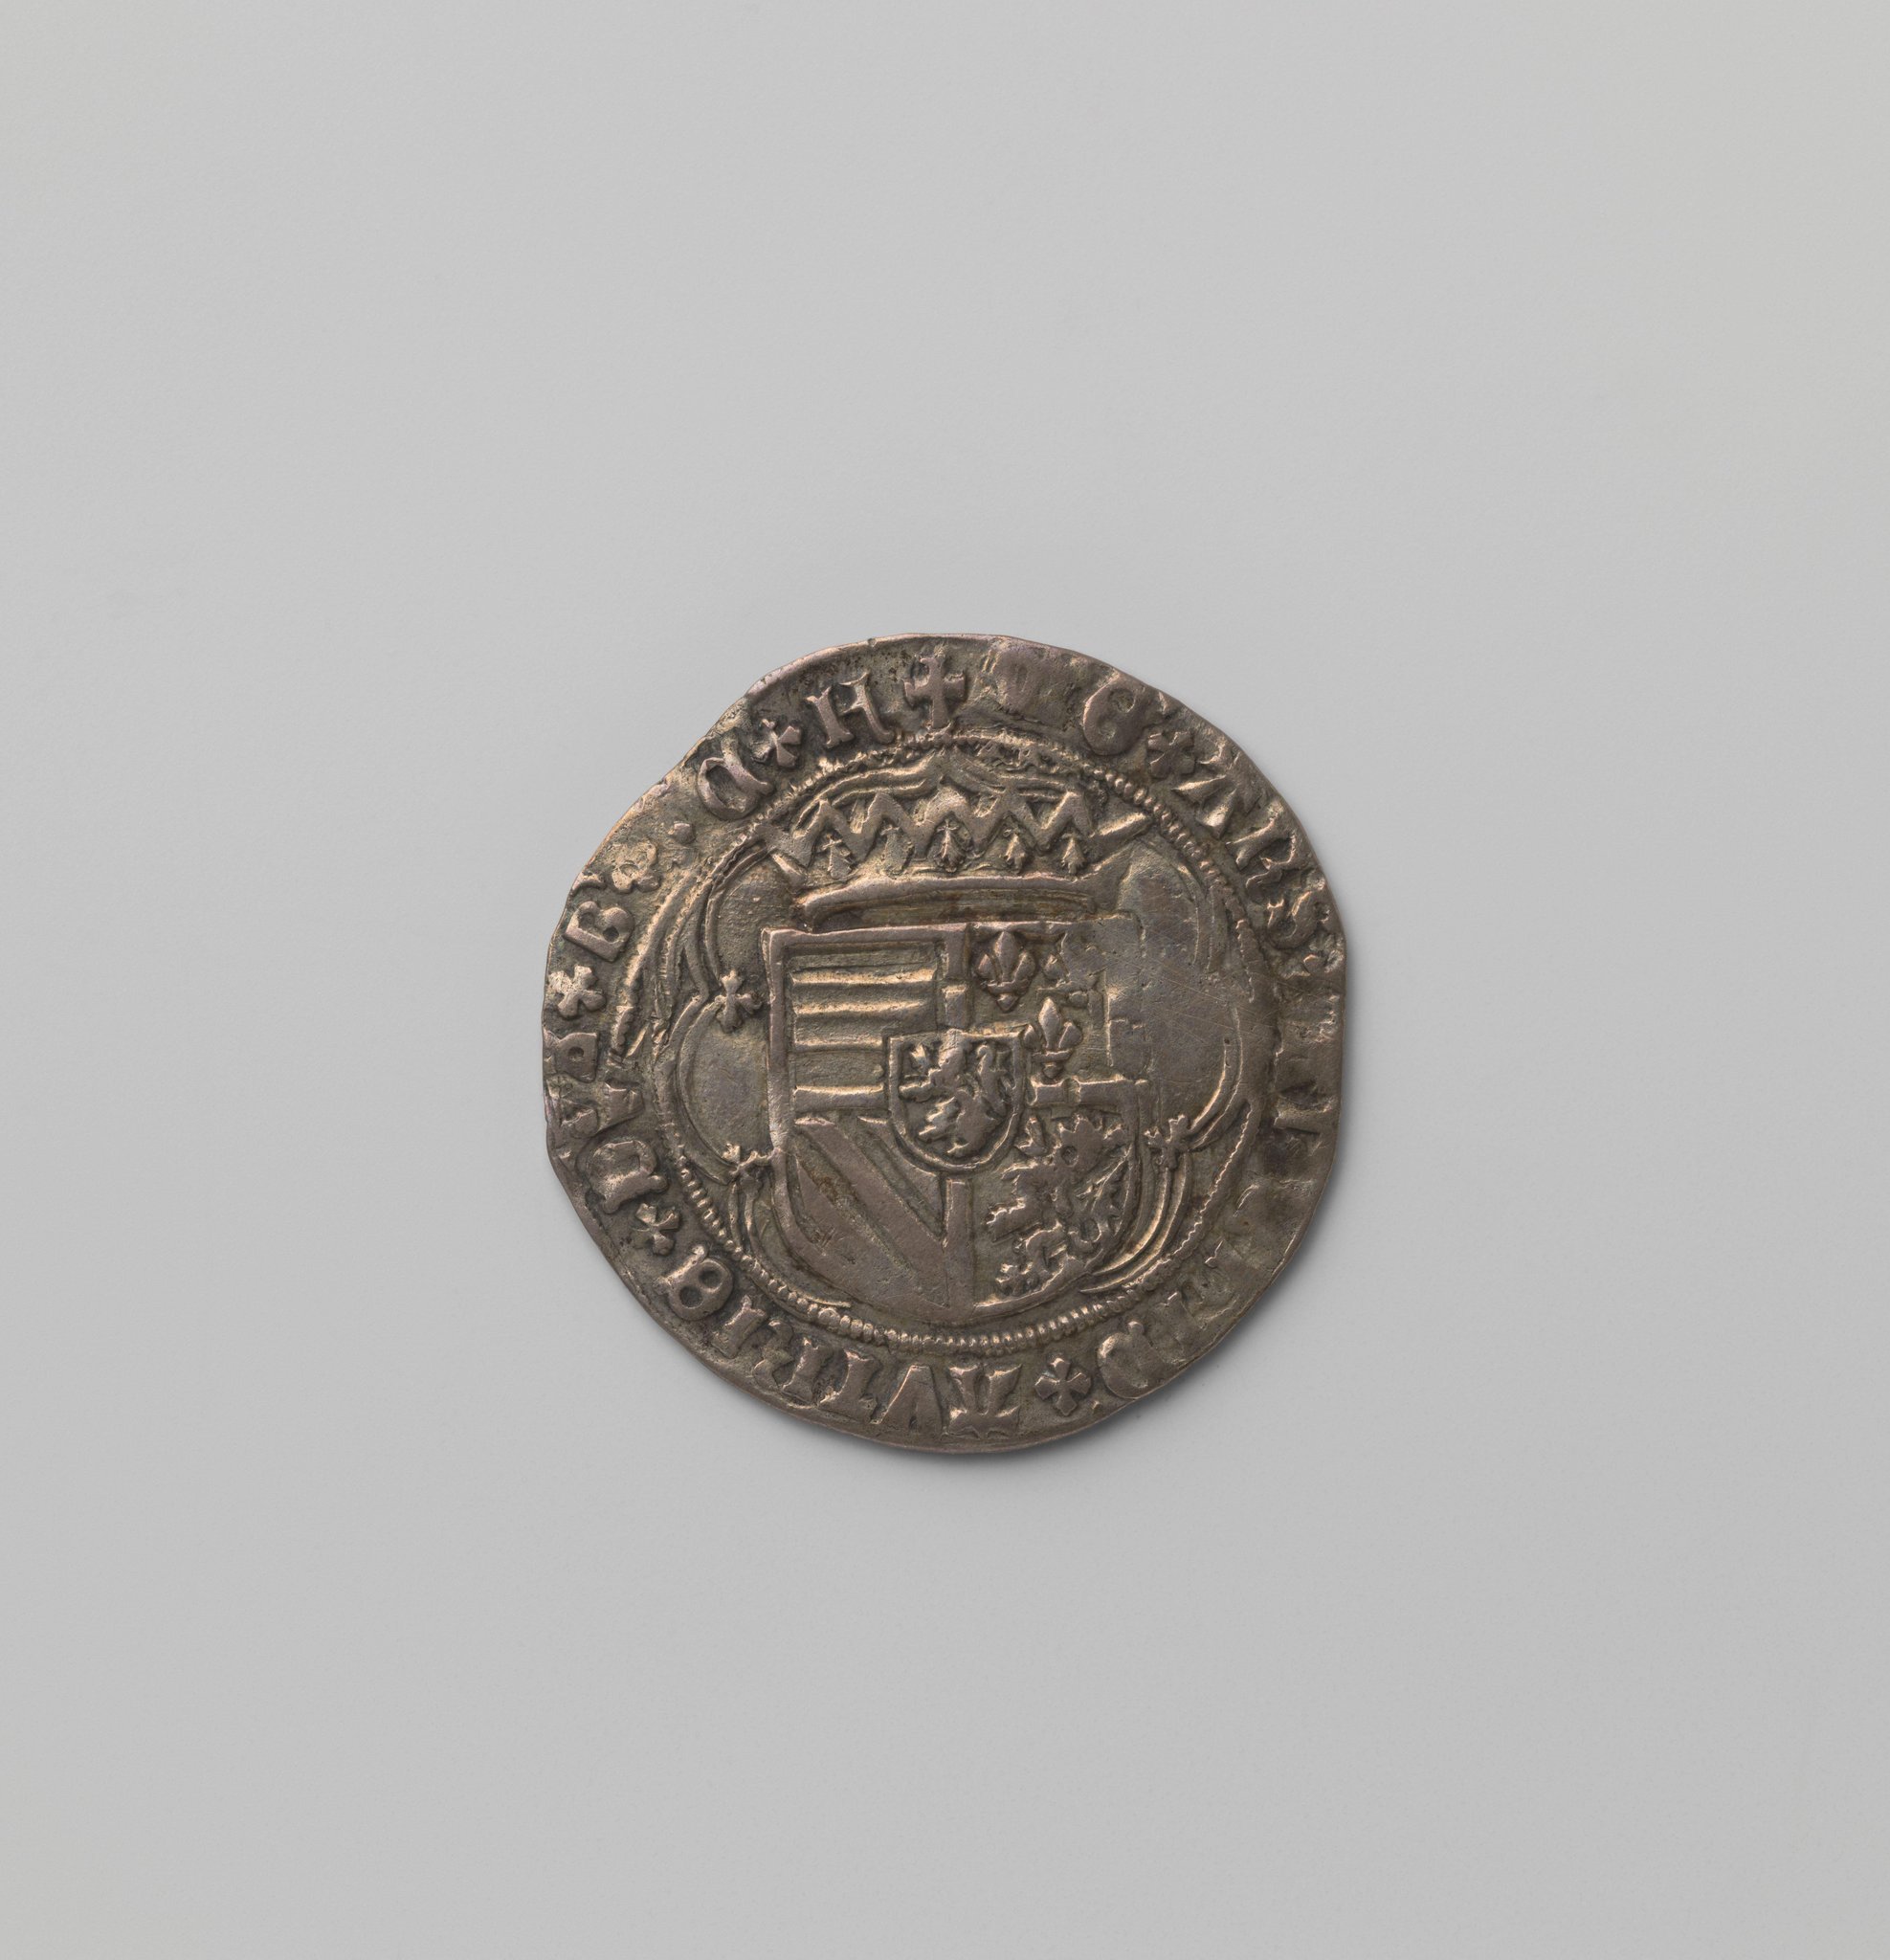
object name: coin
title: Dubbele stuiver uit Vlaanderen van Karel V, op naam van de aarsthertogen, 1506-1515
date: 1506-1515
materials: silver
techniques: striking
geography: bruges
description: Zilveren munt. Voorzijde: in een veelpas gekroond samengesteld wapenschild van Bourgondië. Keerzijde: kort gebloemd kruis, in het hart lelie.